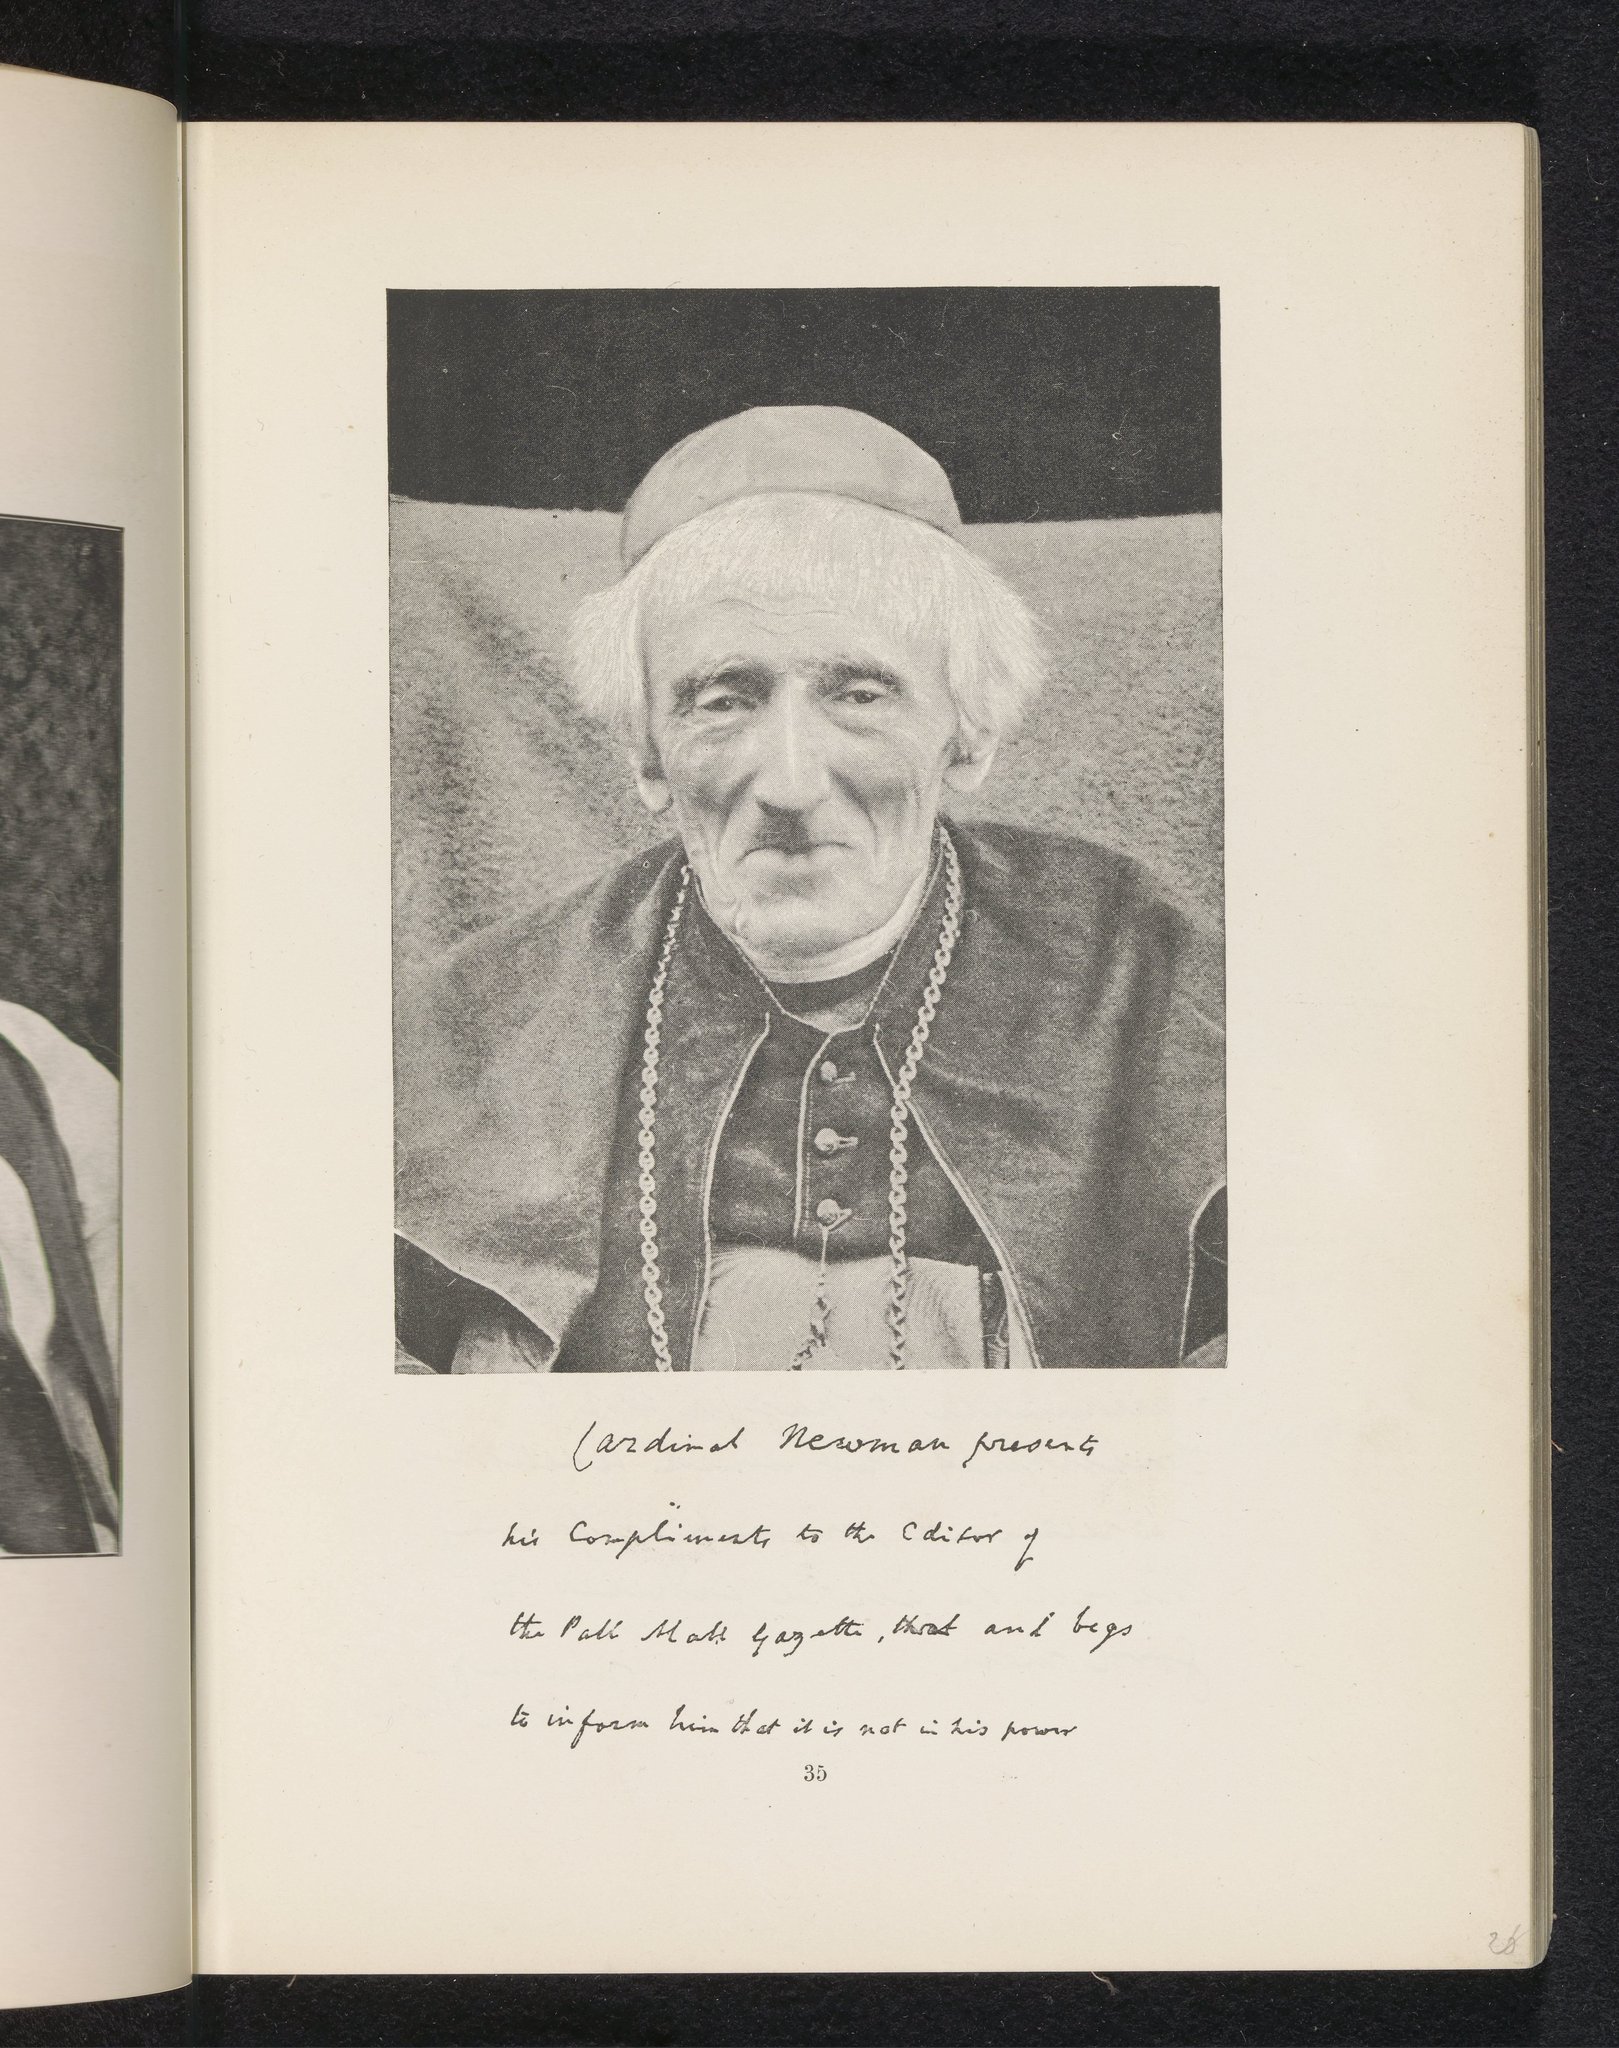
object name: page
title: Portret van John Henry Newman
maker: Anonymous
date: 1881-1891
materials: paper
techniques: autotype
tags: cardinal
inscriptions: inscription